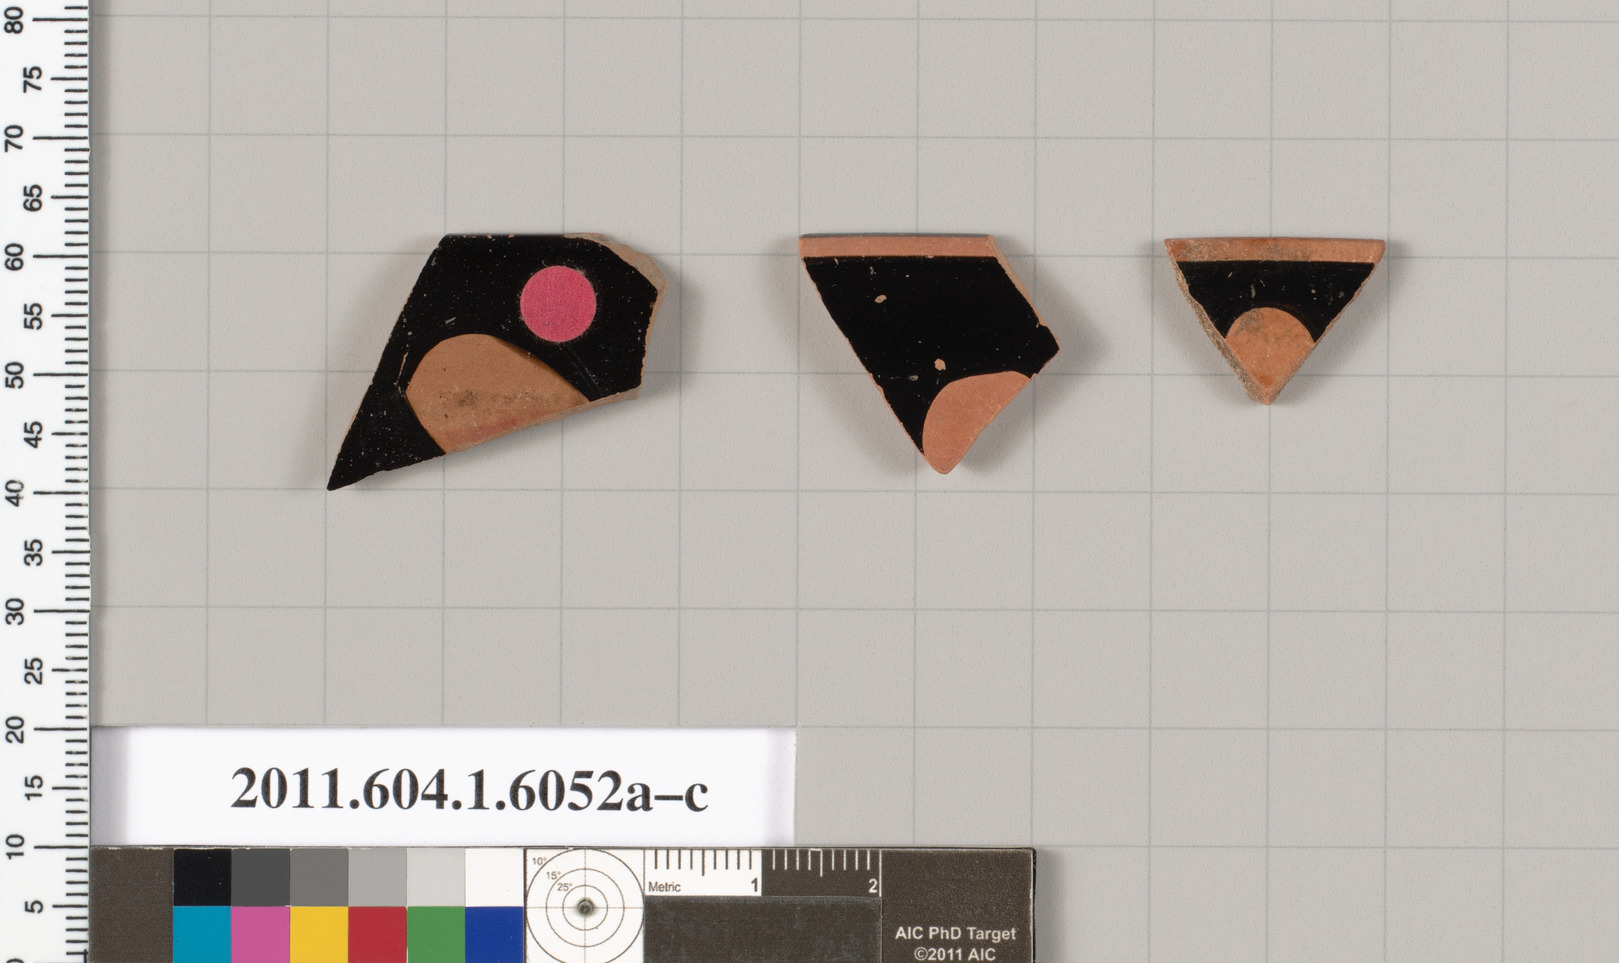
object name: kylix fragment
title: Terracotta rim fragments of kylikes (drinking cups)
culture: greek, attic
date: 510-500 BCE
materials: terracotta